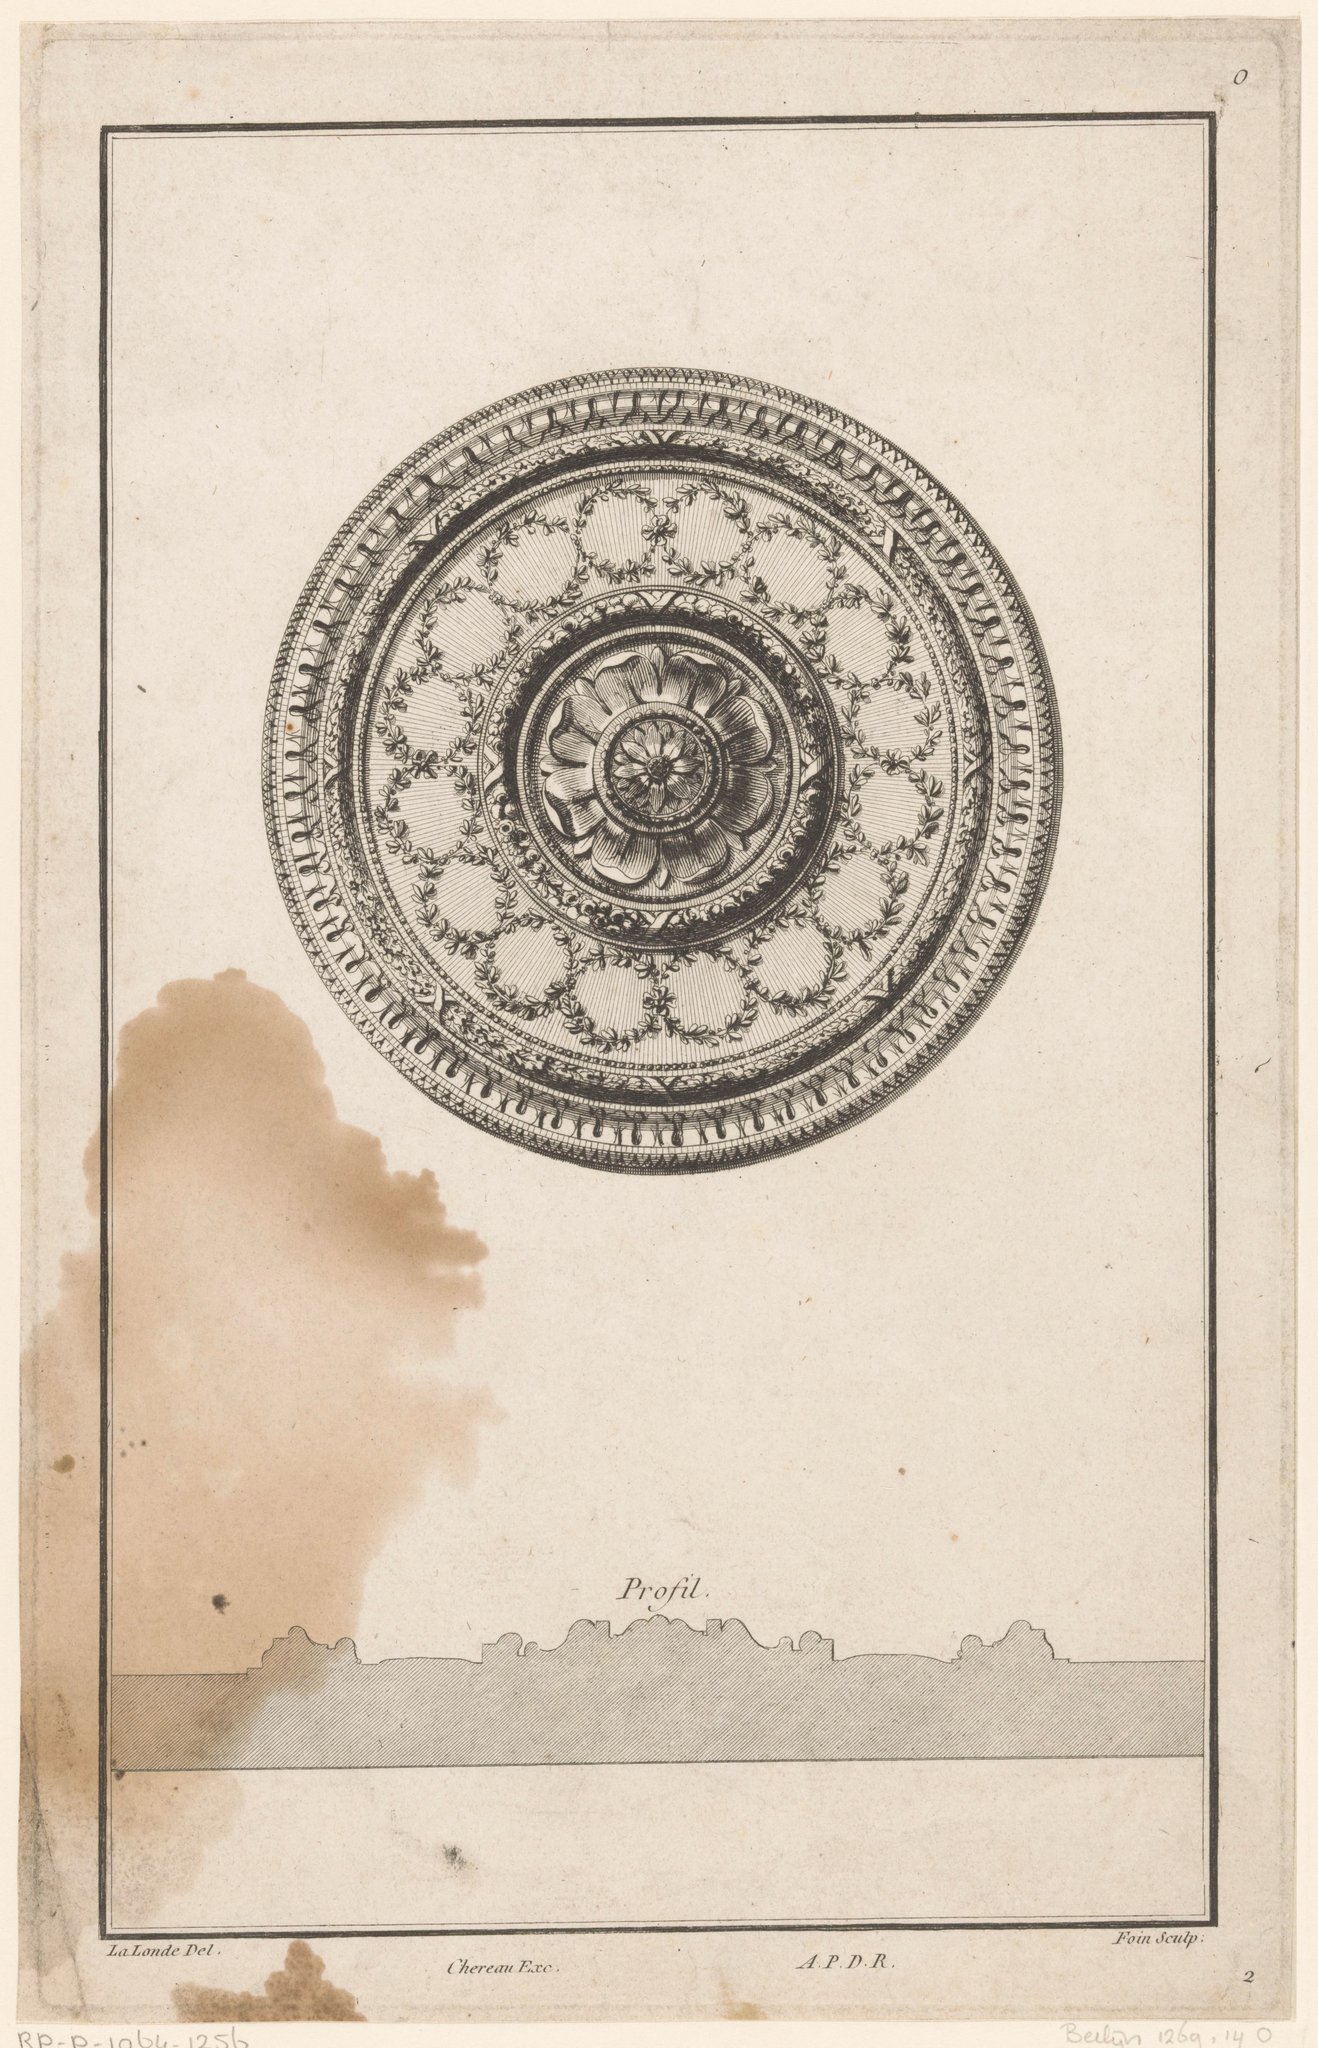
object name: ornament print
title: XIVe Cahier de l'Oeuvre de La Londe O Rosettes de Plafonds avec leurs Profils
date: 1784-1785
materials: paper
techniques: engraving, etching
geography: paris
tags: rosette ~ ornament, tendrils ~ ornament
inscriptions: collector's mark: Lugt 2760, collector's mark: Lugt 2228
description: Rozet met bloemmotief, ranken en randen met bladmotieven. Daaronder het profiel van de rozet.